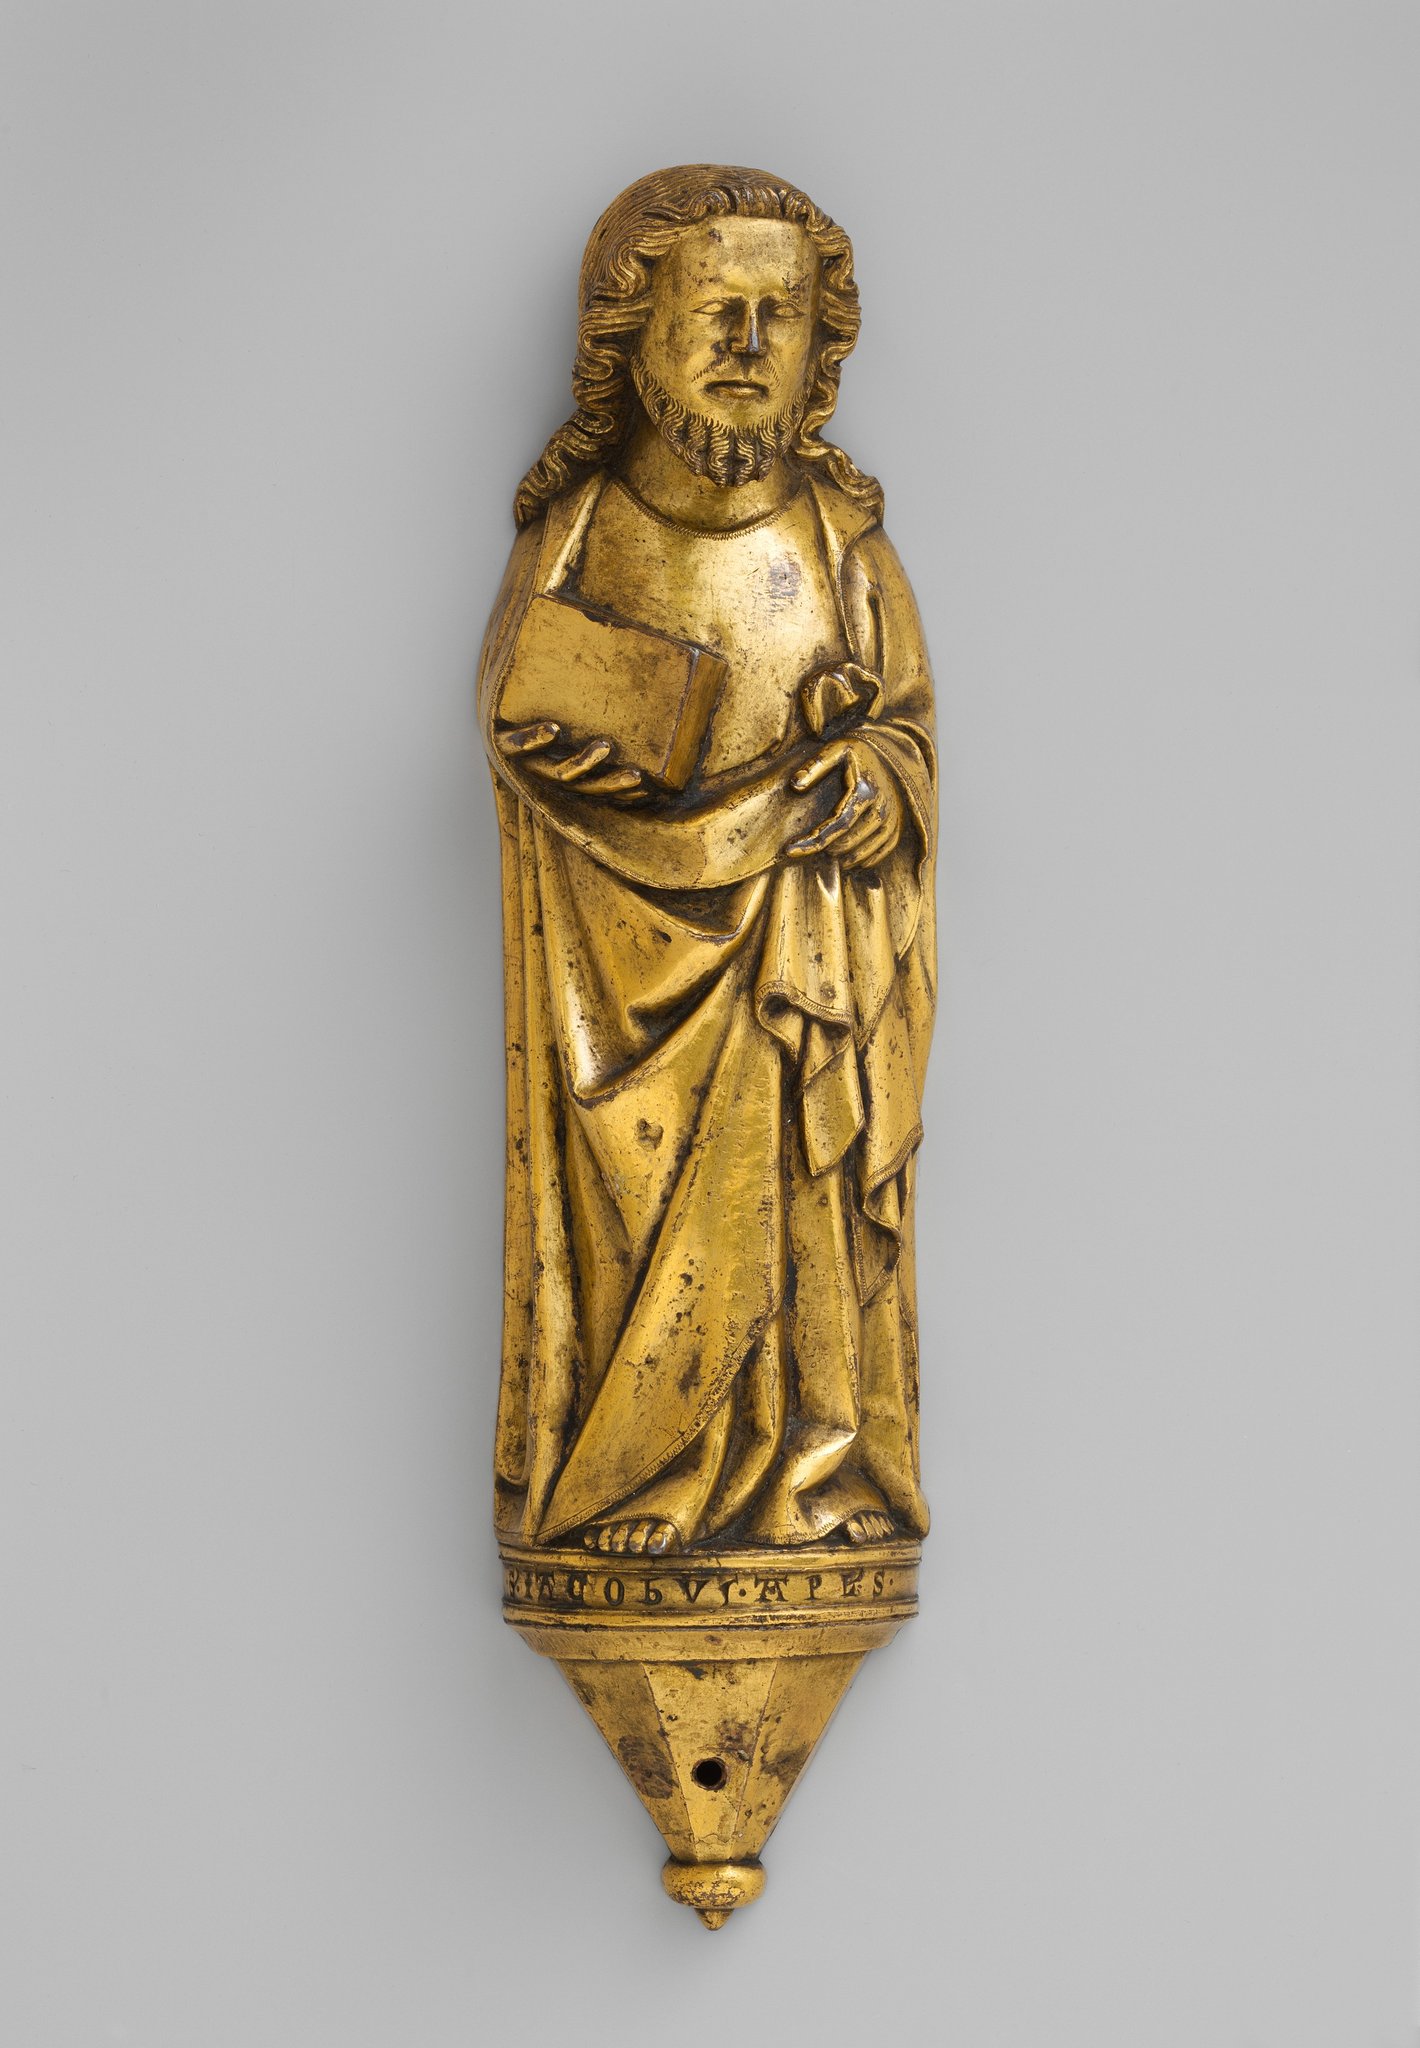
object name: appliqué figure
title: Appliqué Figure of the Apostle James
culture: north german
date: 1350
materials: copper alloy, gilt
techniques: casting